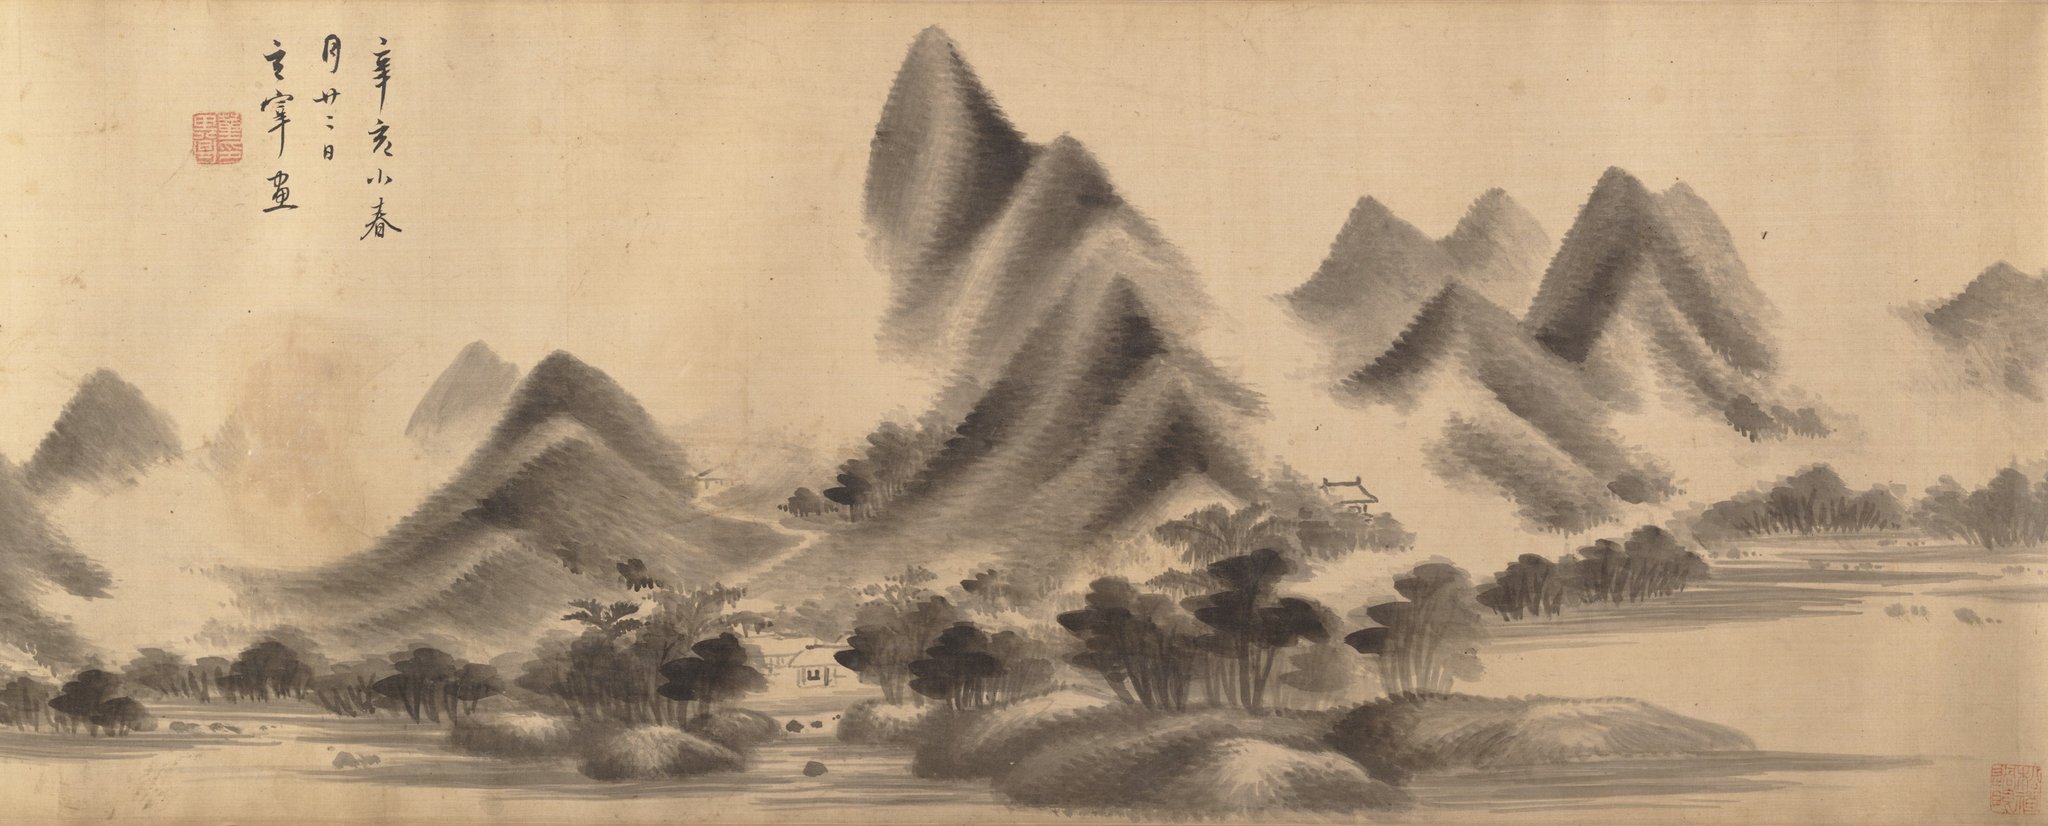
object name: handscroll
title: Landscape in the Style of Mi Fu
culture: chinese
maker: dong qichang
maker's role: artist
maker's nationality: chinese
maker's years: 1555-1636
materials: ink, textile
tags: mountains,landscapes